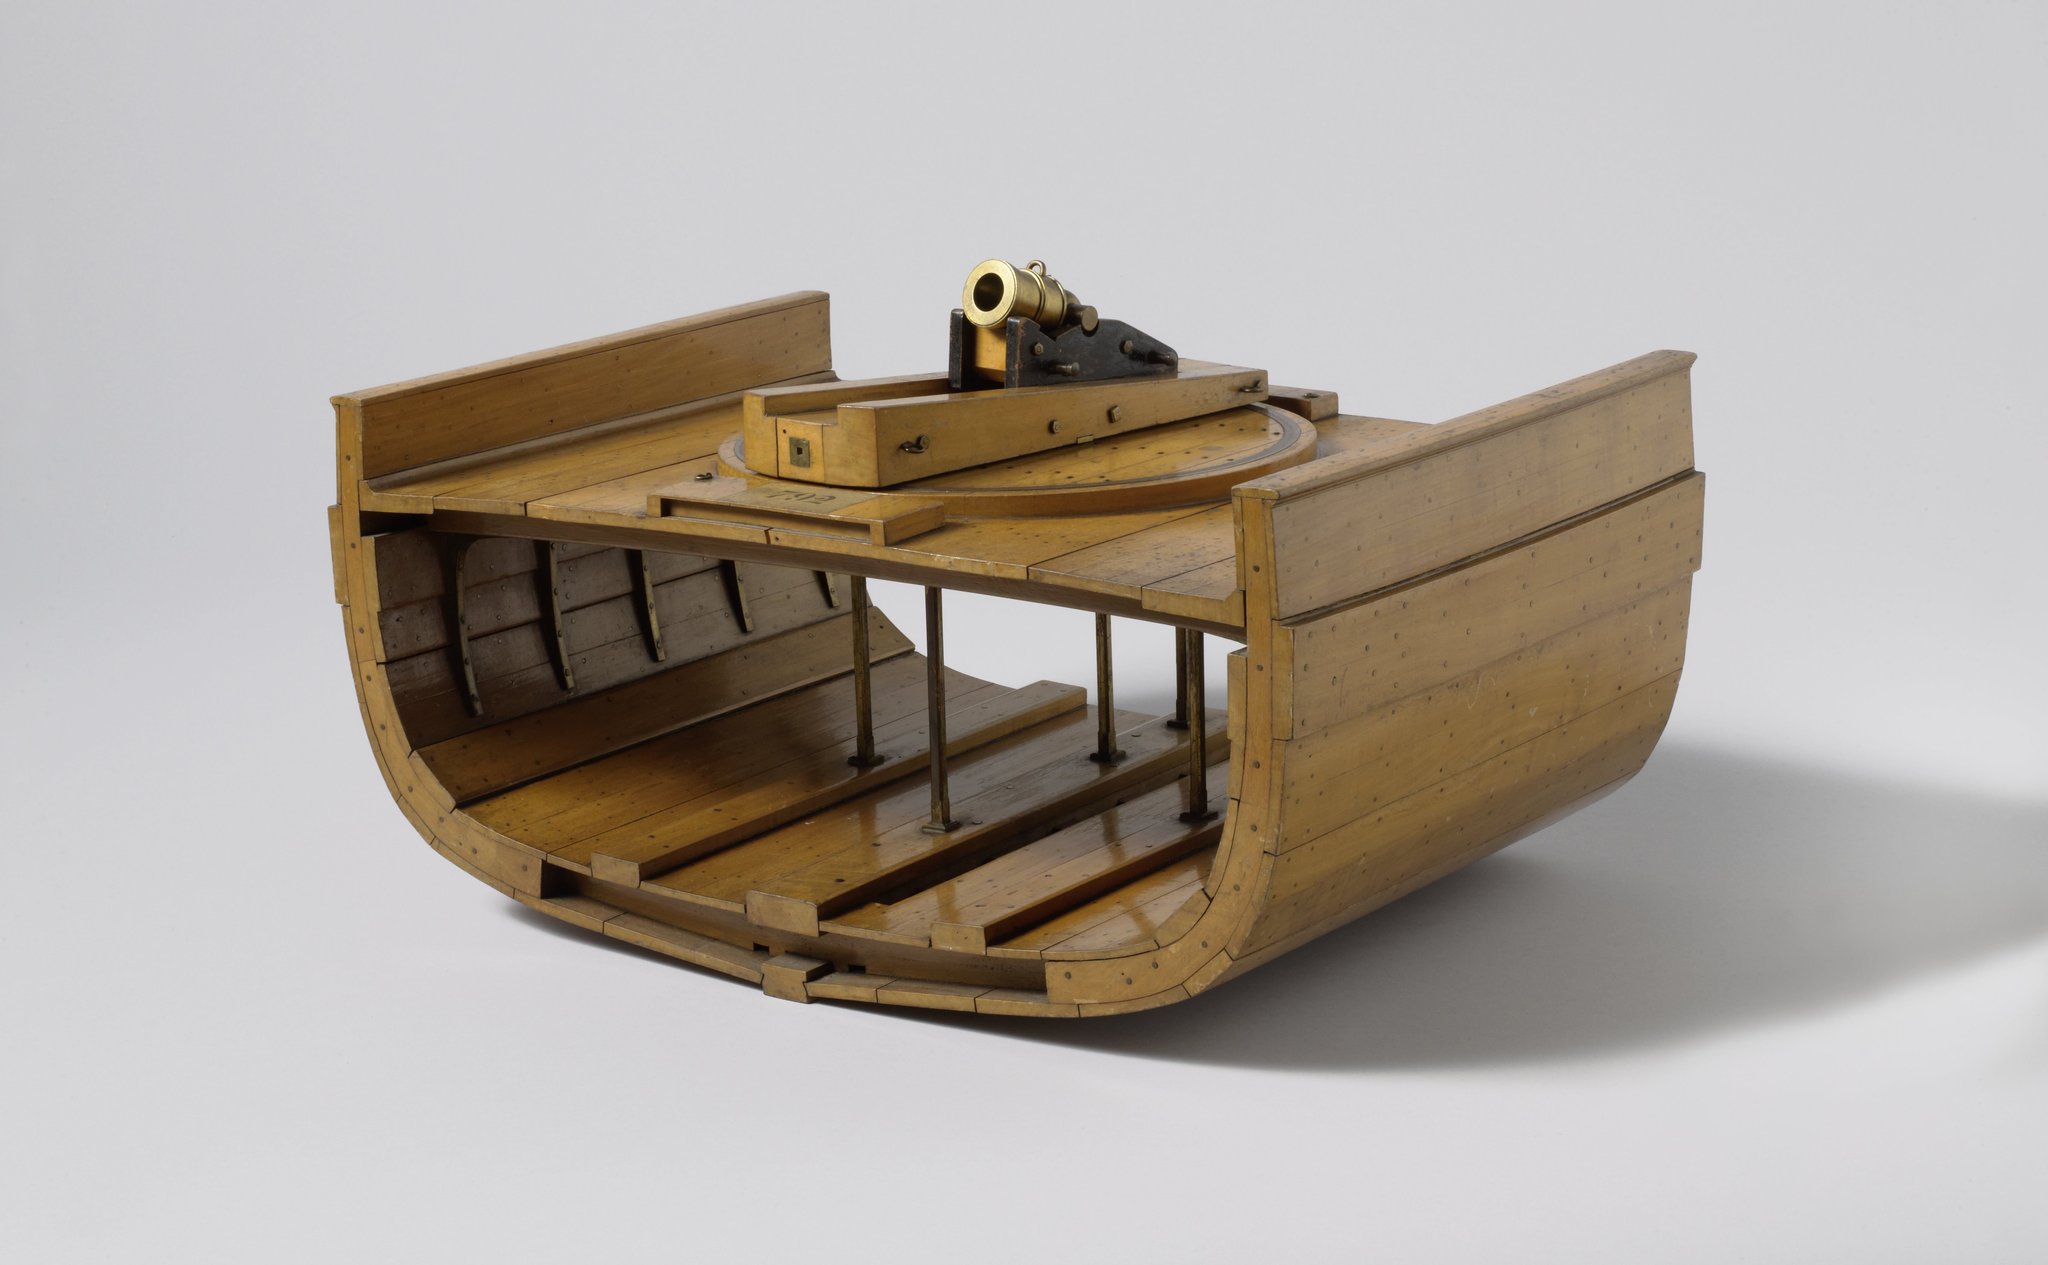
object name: demonstration model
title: Model of a 20-cm Mortar on a Pivot Undercarriage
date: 1834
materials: brass, wood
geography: rotterdam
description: This model represents a twenty-inch calibre mortar of the kind fitted on gunboats. The weight of the mortar and its recoil when fired required considerable strengthening of the deck both below and around the weapon. The mortar stands on a sliding mount placed on a turntable. This allowed the weapon to be fired in any direction.